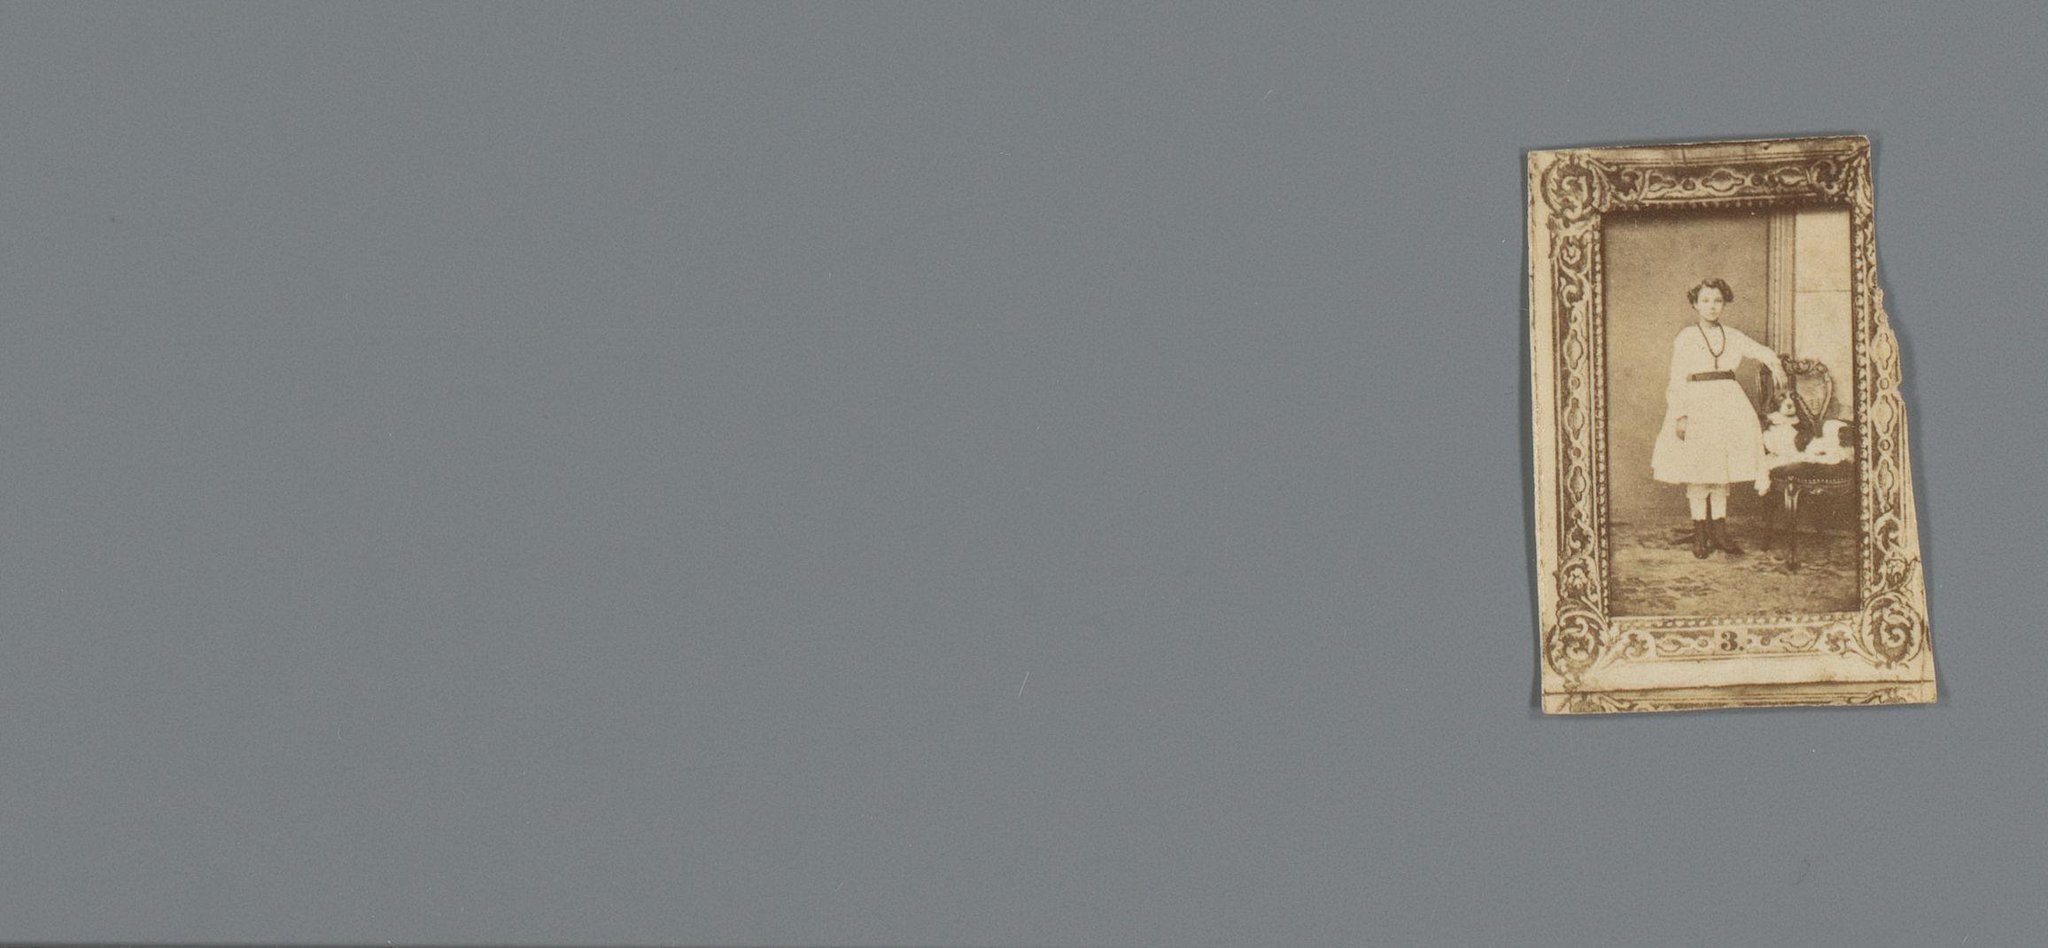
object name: photograph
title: Miniatuurportret van een onbekend jong persoon naast een hond, het geheel omlijst door een decoratieve rand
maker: Anonymous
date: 1851-1900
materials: paper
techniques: albumen print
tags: anonymous historical person portrayed alone, dog